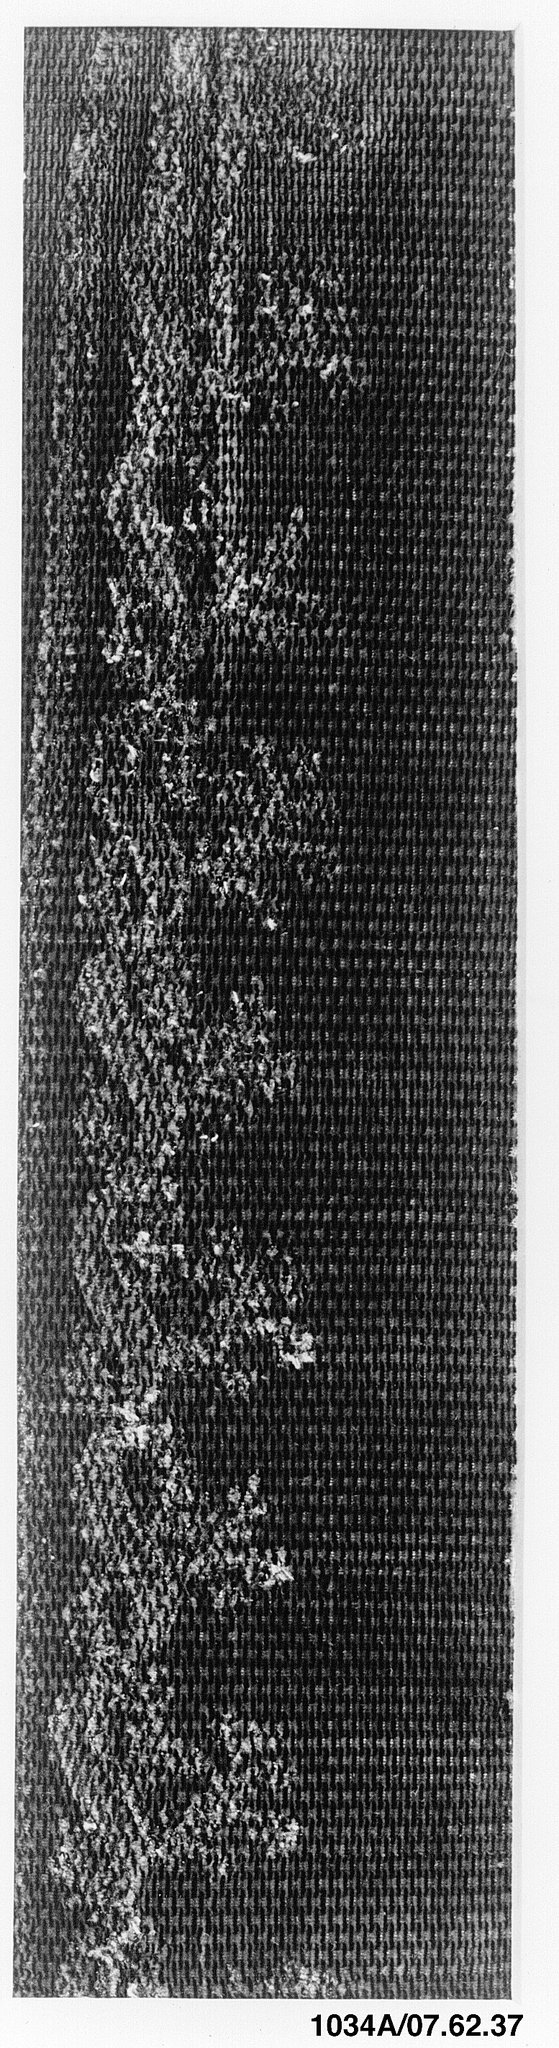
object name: border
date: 1801-1833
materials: silk